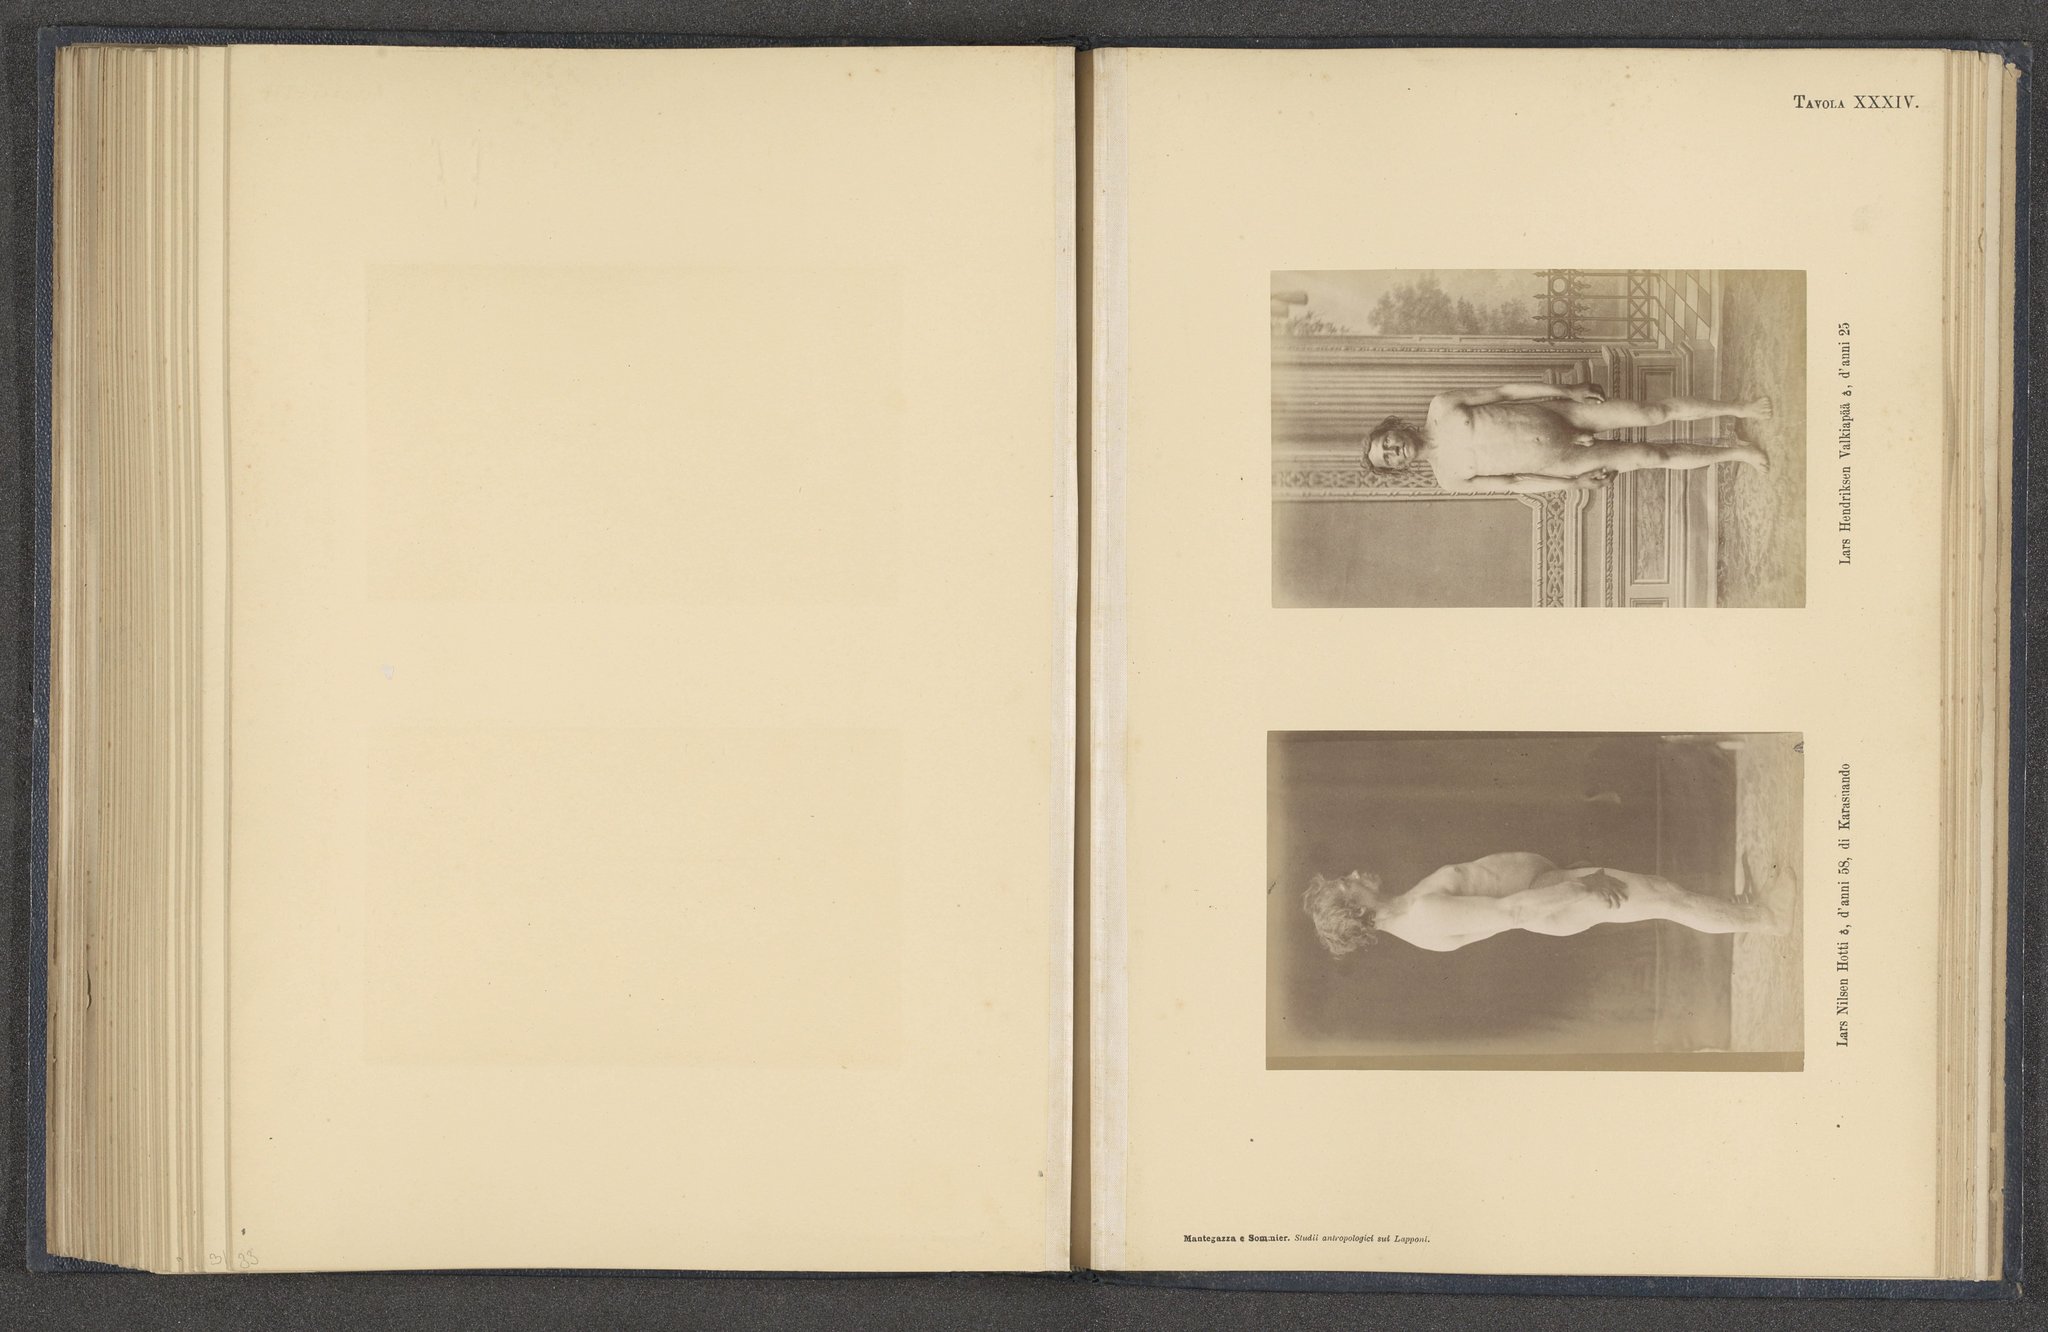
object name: page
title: Twee naaktfoto's van Lars Nilsen Hotti en Lars Hendriksen Valkiapää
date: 1870-1880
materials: paper, photographic support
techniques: albumen print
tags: man (showing himself) undressed, quasi-nude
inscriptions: number: ‘Tavola XXXIV.’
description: Links een zijaanzicht van Lars Nilsen Hotti, rechts een vooraanzicht van Lars Hendriksen Valkiapää.